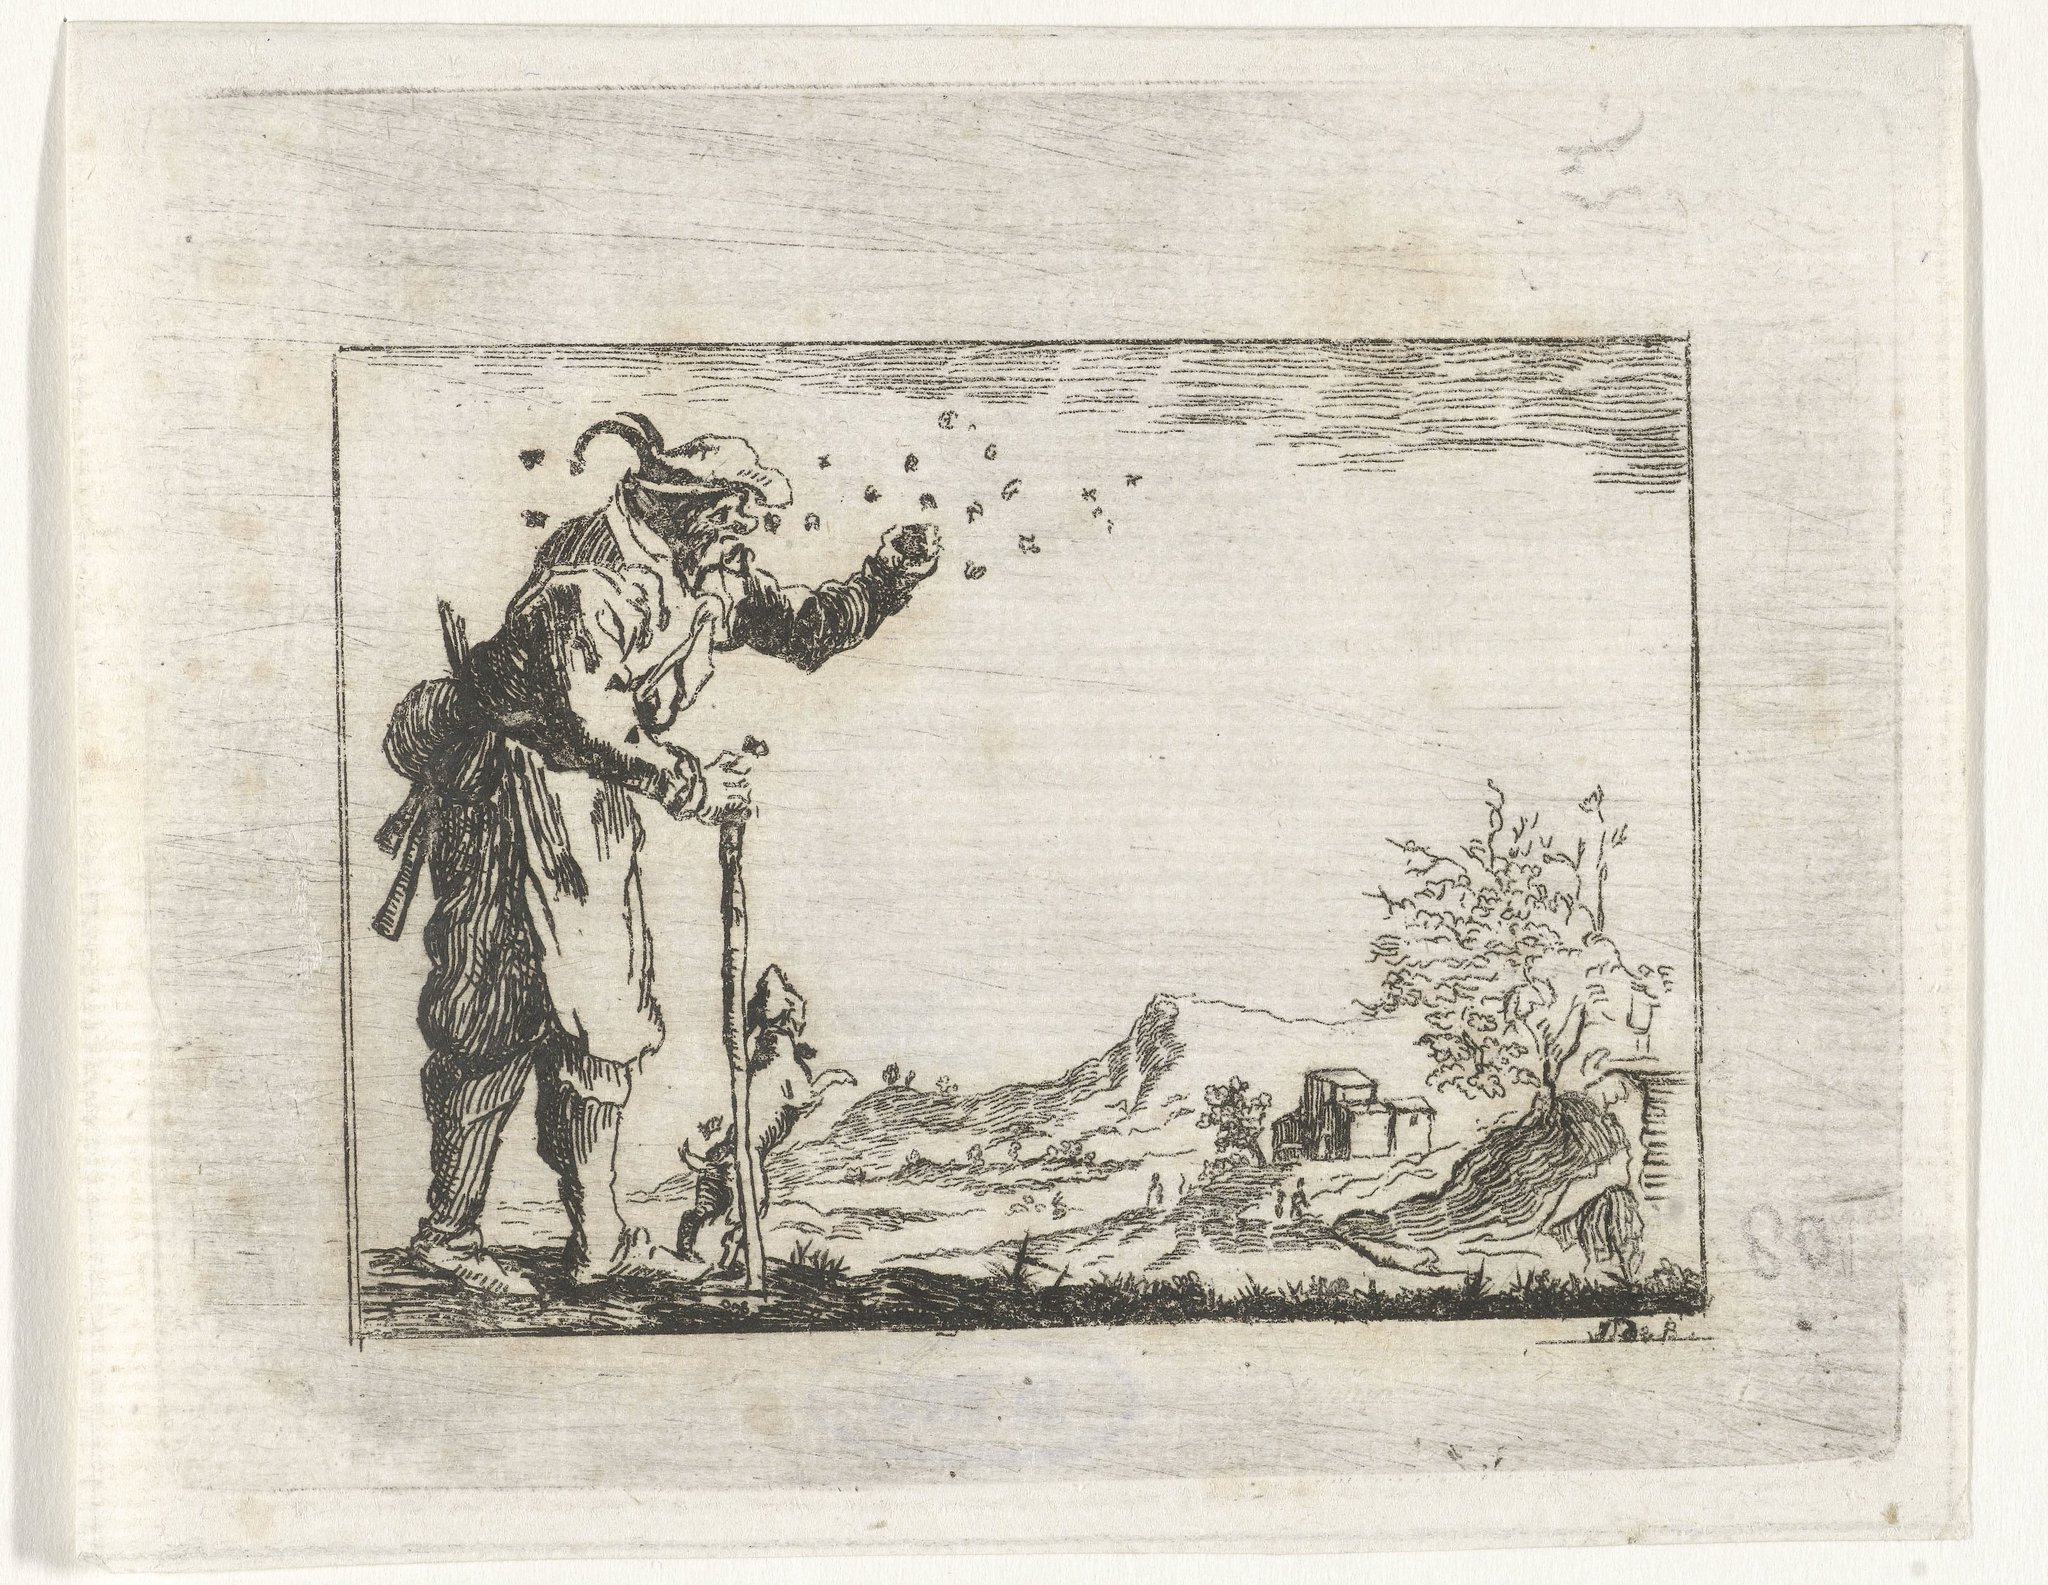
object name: print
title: Man met de vliegen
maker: reinierus albertus ludovicus baron van isendoorn à blois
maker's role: print maker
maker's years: 1786-1856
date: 1796-1856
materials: paper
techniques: etching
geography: vaassen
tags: dog, insects: fly (+ man and animal)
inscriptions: collector's mark: Lugt 2228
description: Een man slaat met zijn ene hand naar een zwerm vliegen, in zijn andere hand houdt hij een wandelstok. Naast hem zijn hond, die opspringt naar de vliegen. Op de achtergrond een heuvellandschap.